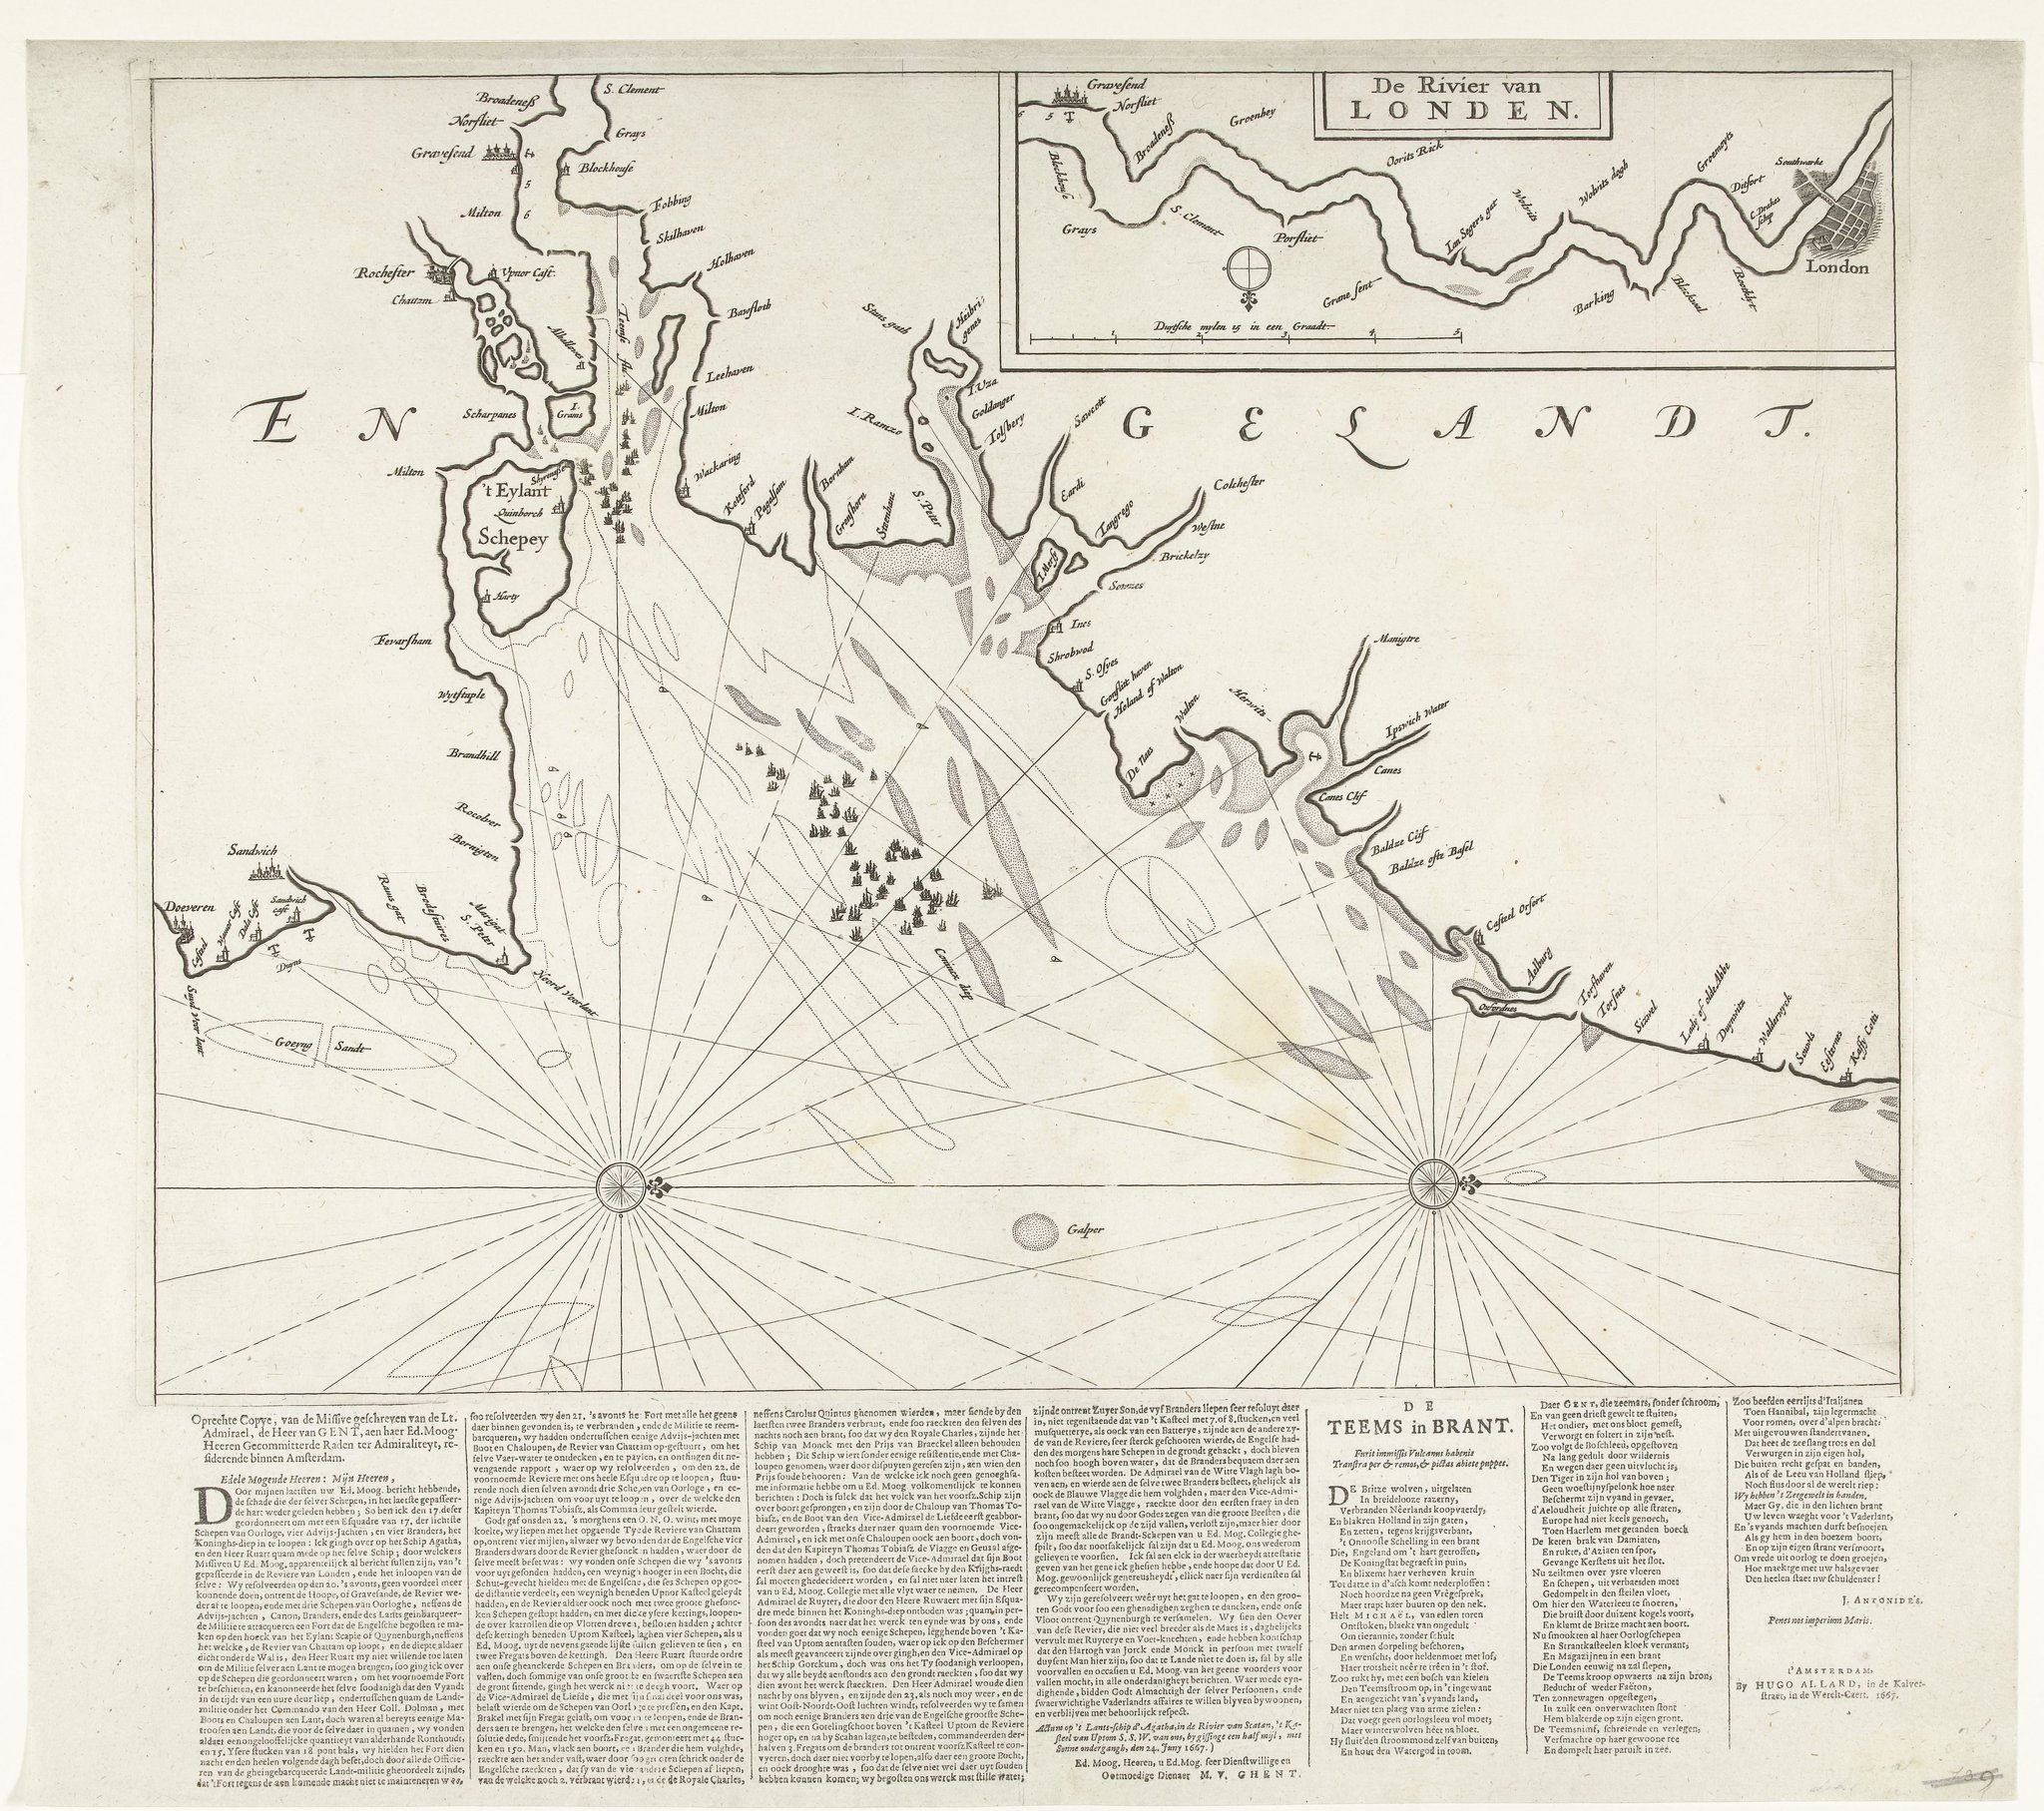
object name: print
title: Kaart van monding van de Theems met de Tocht naar Chatham, 1667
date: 1667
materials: paper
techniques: engraving, letterpress printing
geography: amsterdam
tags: flushing, michiel adriaenszoon de ruyter, willem joseph baron van gendt, maps of separate countries or regions, battle (+ naval force), thames, raid on the medway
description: Kaart van monding van de Theems waarop de Tocht naar Chatham door de Staatse vloot onder admiraal Michiel Adriaenszoon de Ruyter is aangegeven, 20-23 juni 1667. Onder de plaat gedrukt in 4 kolommen een brief van admiraal Willem van Ghent geschreven aan boord van de Agatha en gericht aan de Admiraliteit van Amsterdam met een beschrijving van het verloop van de strijd. Hiernaast een vers op de overwinning in 3 kolommen.